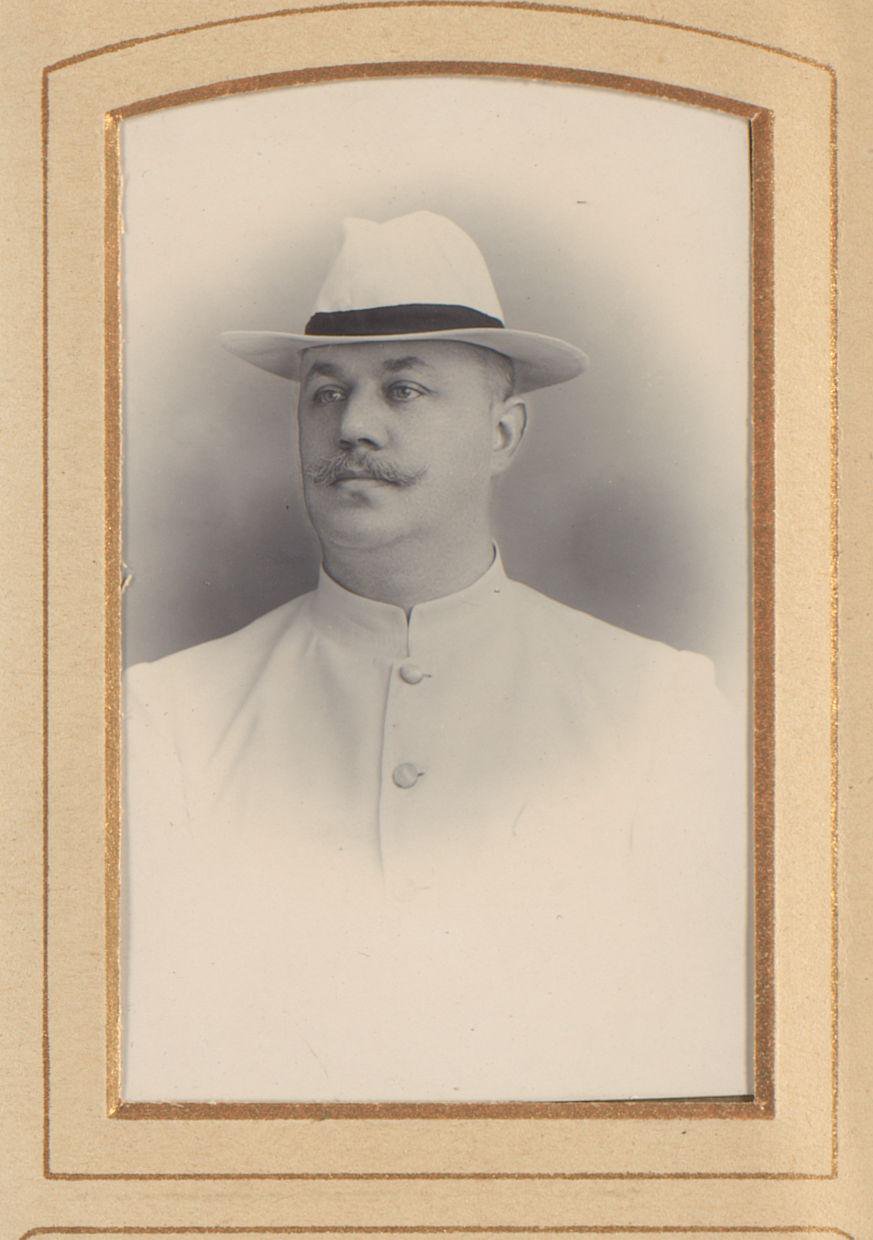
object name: photograph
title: Portret van een man met hoed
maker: otto hisgen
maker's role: fotograaf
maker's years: 1874-1944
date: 1905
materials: cardboard, photographic support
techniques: collodion silver print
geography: java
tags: historical persons, head-gear: hat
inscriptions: annotation: ‘[Albert v/d Lier]/ peetoom van Albertje/ nov. 1905/ a.’, inscription: ‘Atelier/ O. Hisgen & Co./ Semarang/ Java/’